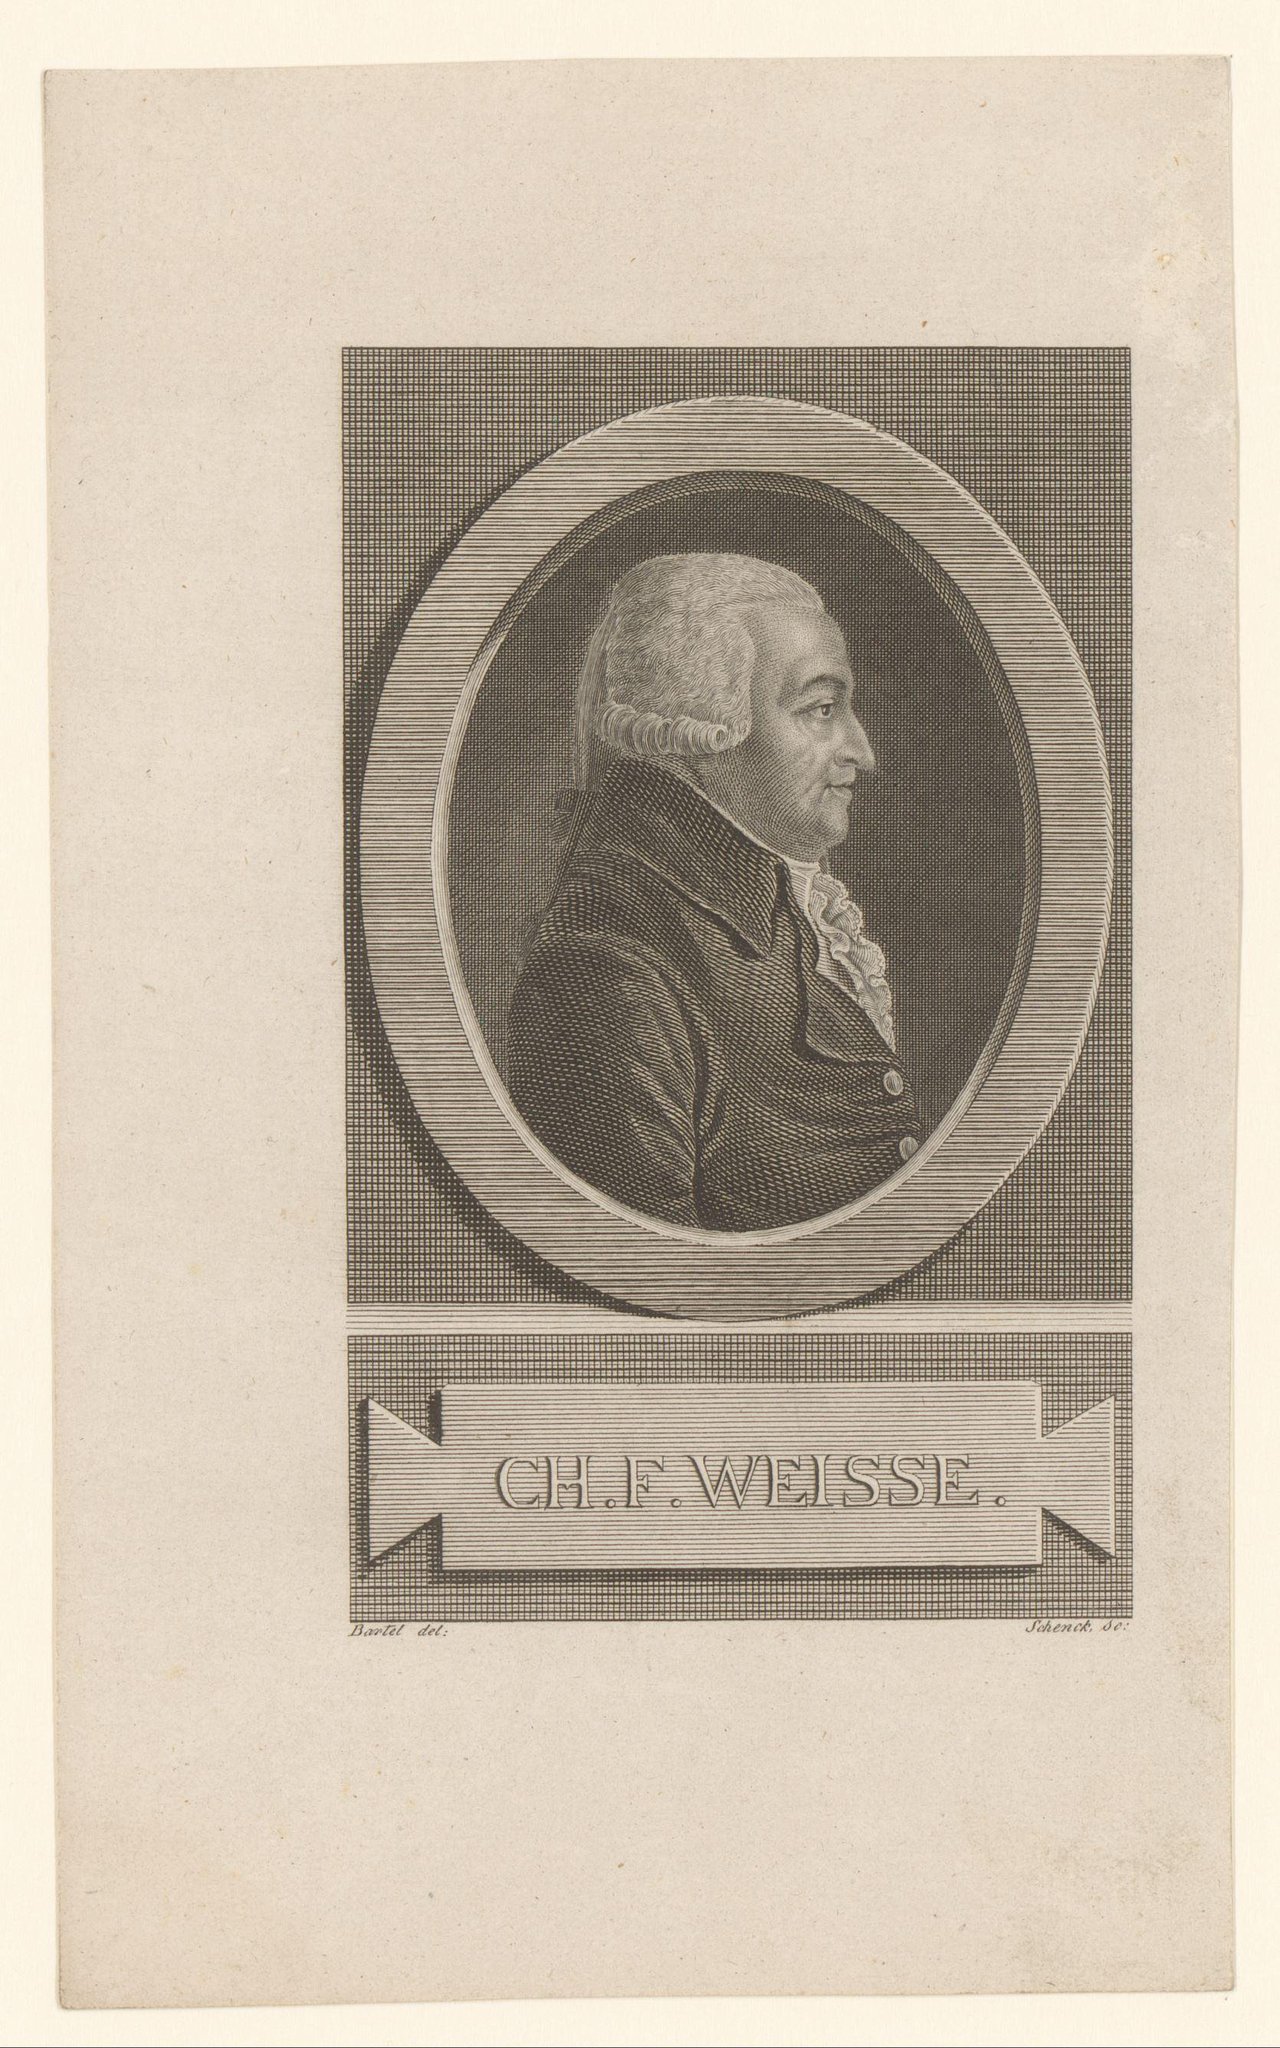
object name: print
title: Portret van Christian Felix Weisse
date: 1700-1799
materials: paper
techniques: etching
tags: historical persons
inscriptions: collector's mark: Lugt 2228